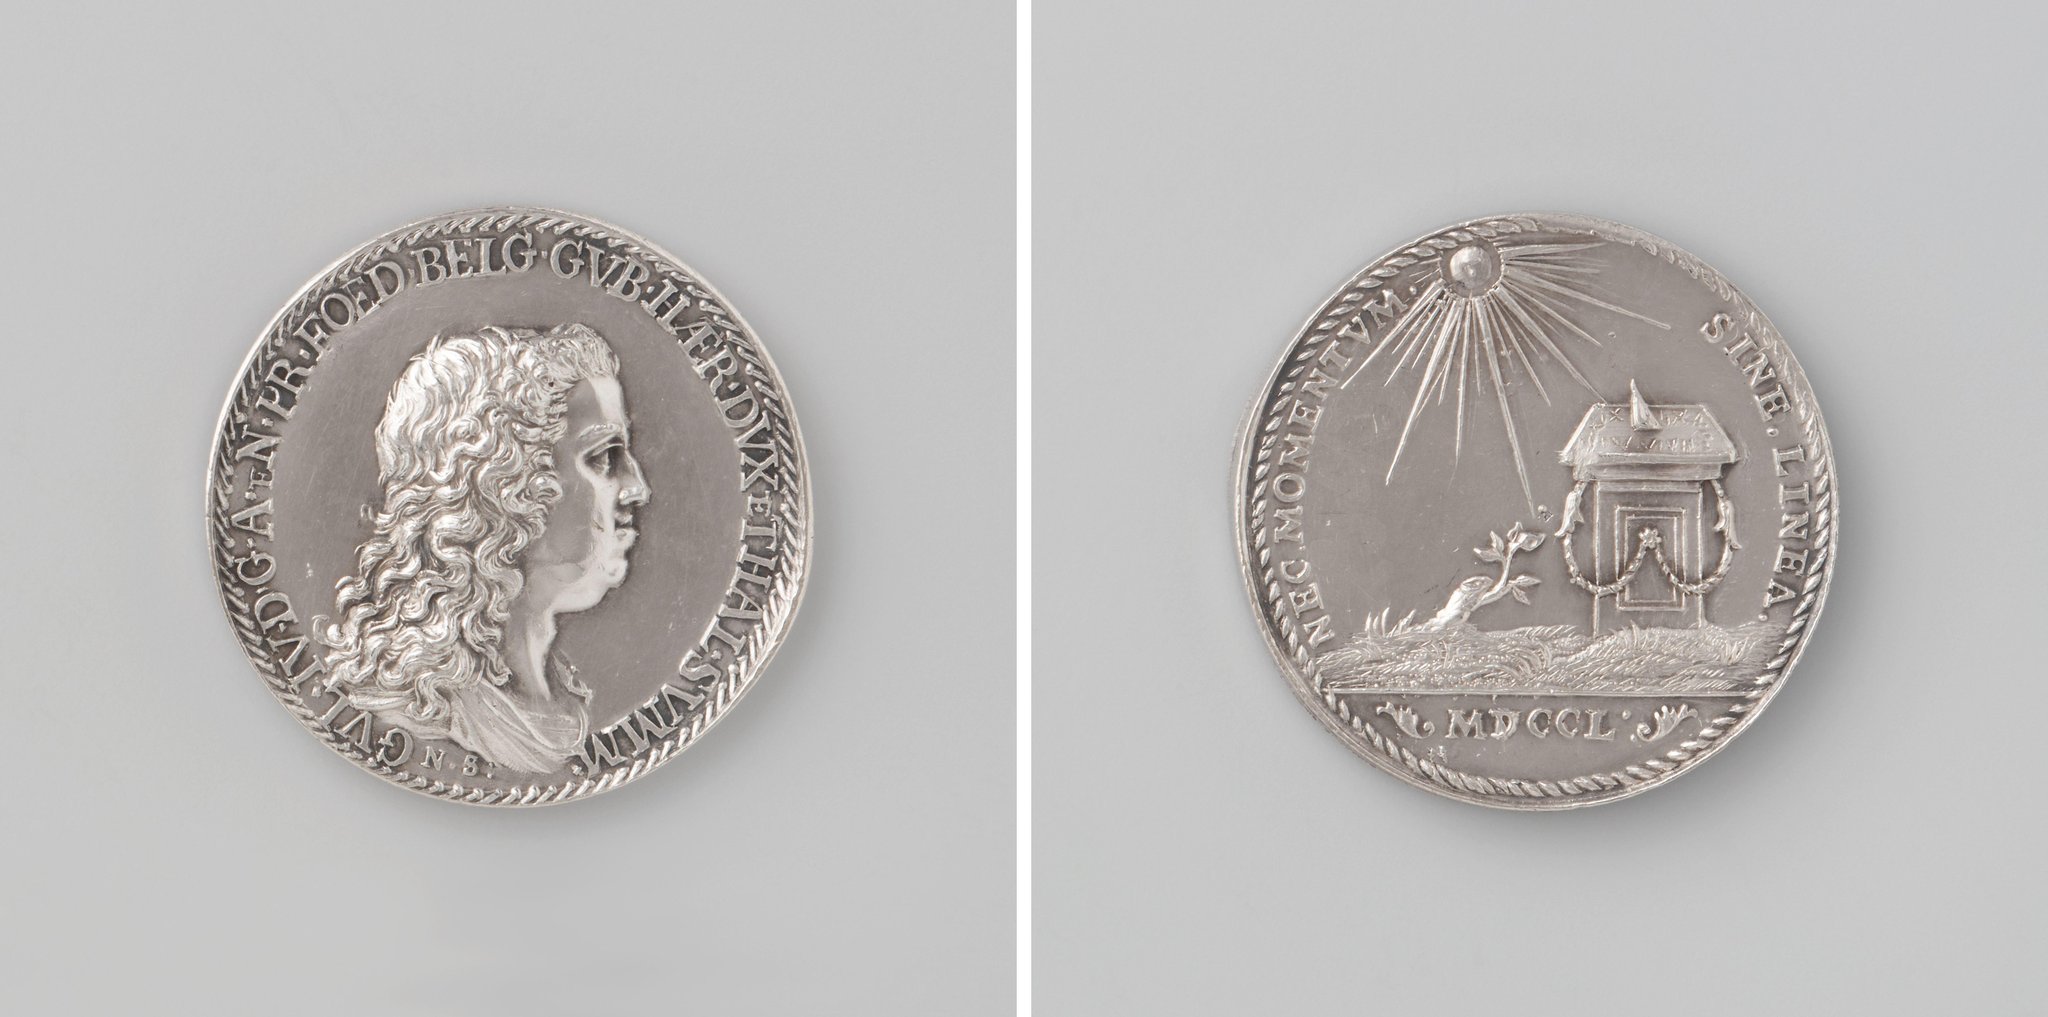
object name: history medal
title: Willem IV, prins van Oranje-Nassau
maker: johann lorenz natter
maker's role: medailleur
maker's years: 1705-1763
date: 1750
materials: silver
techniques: striking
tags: the hague, willem iv (prins van oranje-nassau)